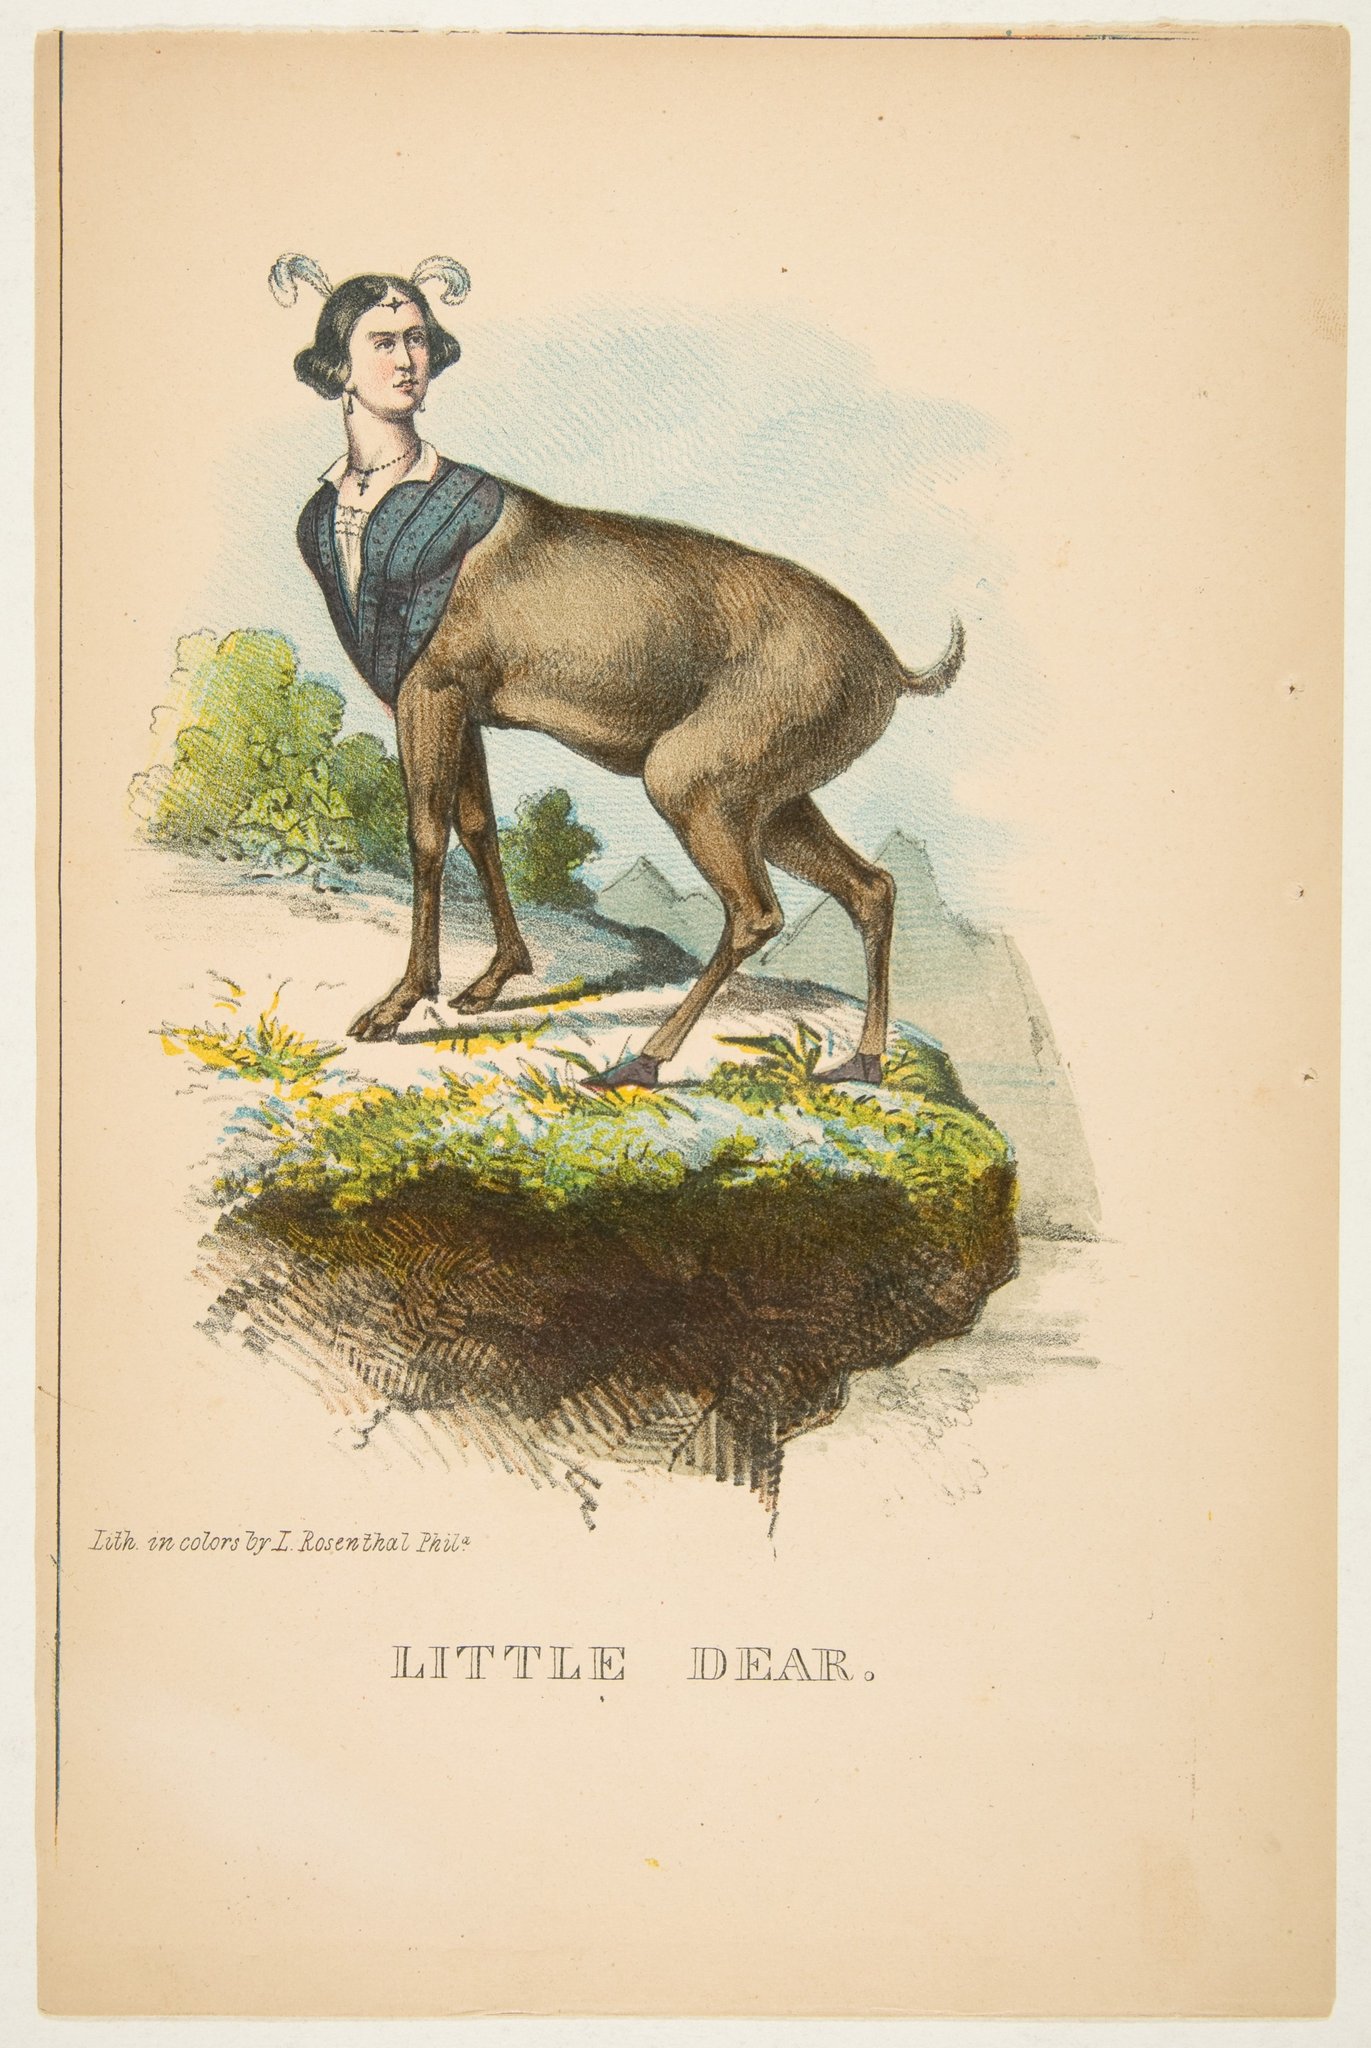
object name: print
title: Little Dear, from "The Comic Natural History of the Human Race"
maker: henry louis stephens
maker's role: artist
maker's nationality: american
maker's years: 1824-1882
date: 1851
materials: watercolor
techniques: lithograph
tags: satire,heads,deer